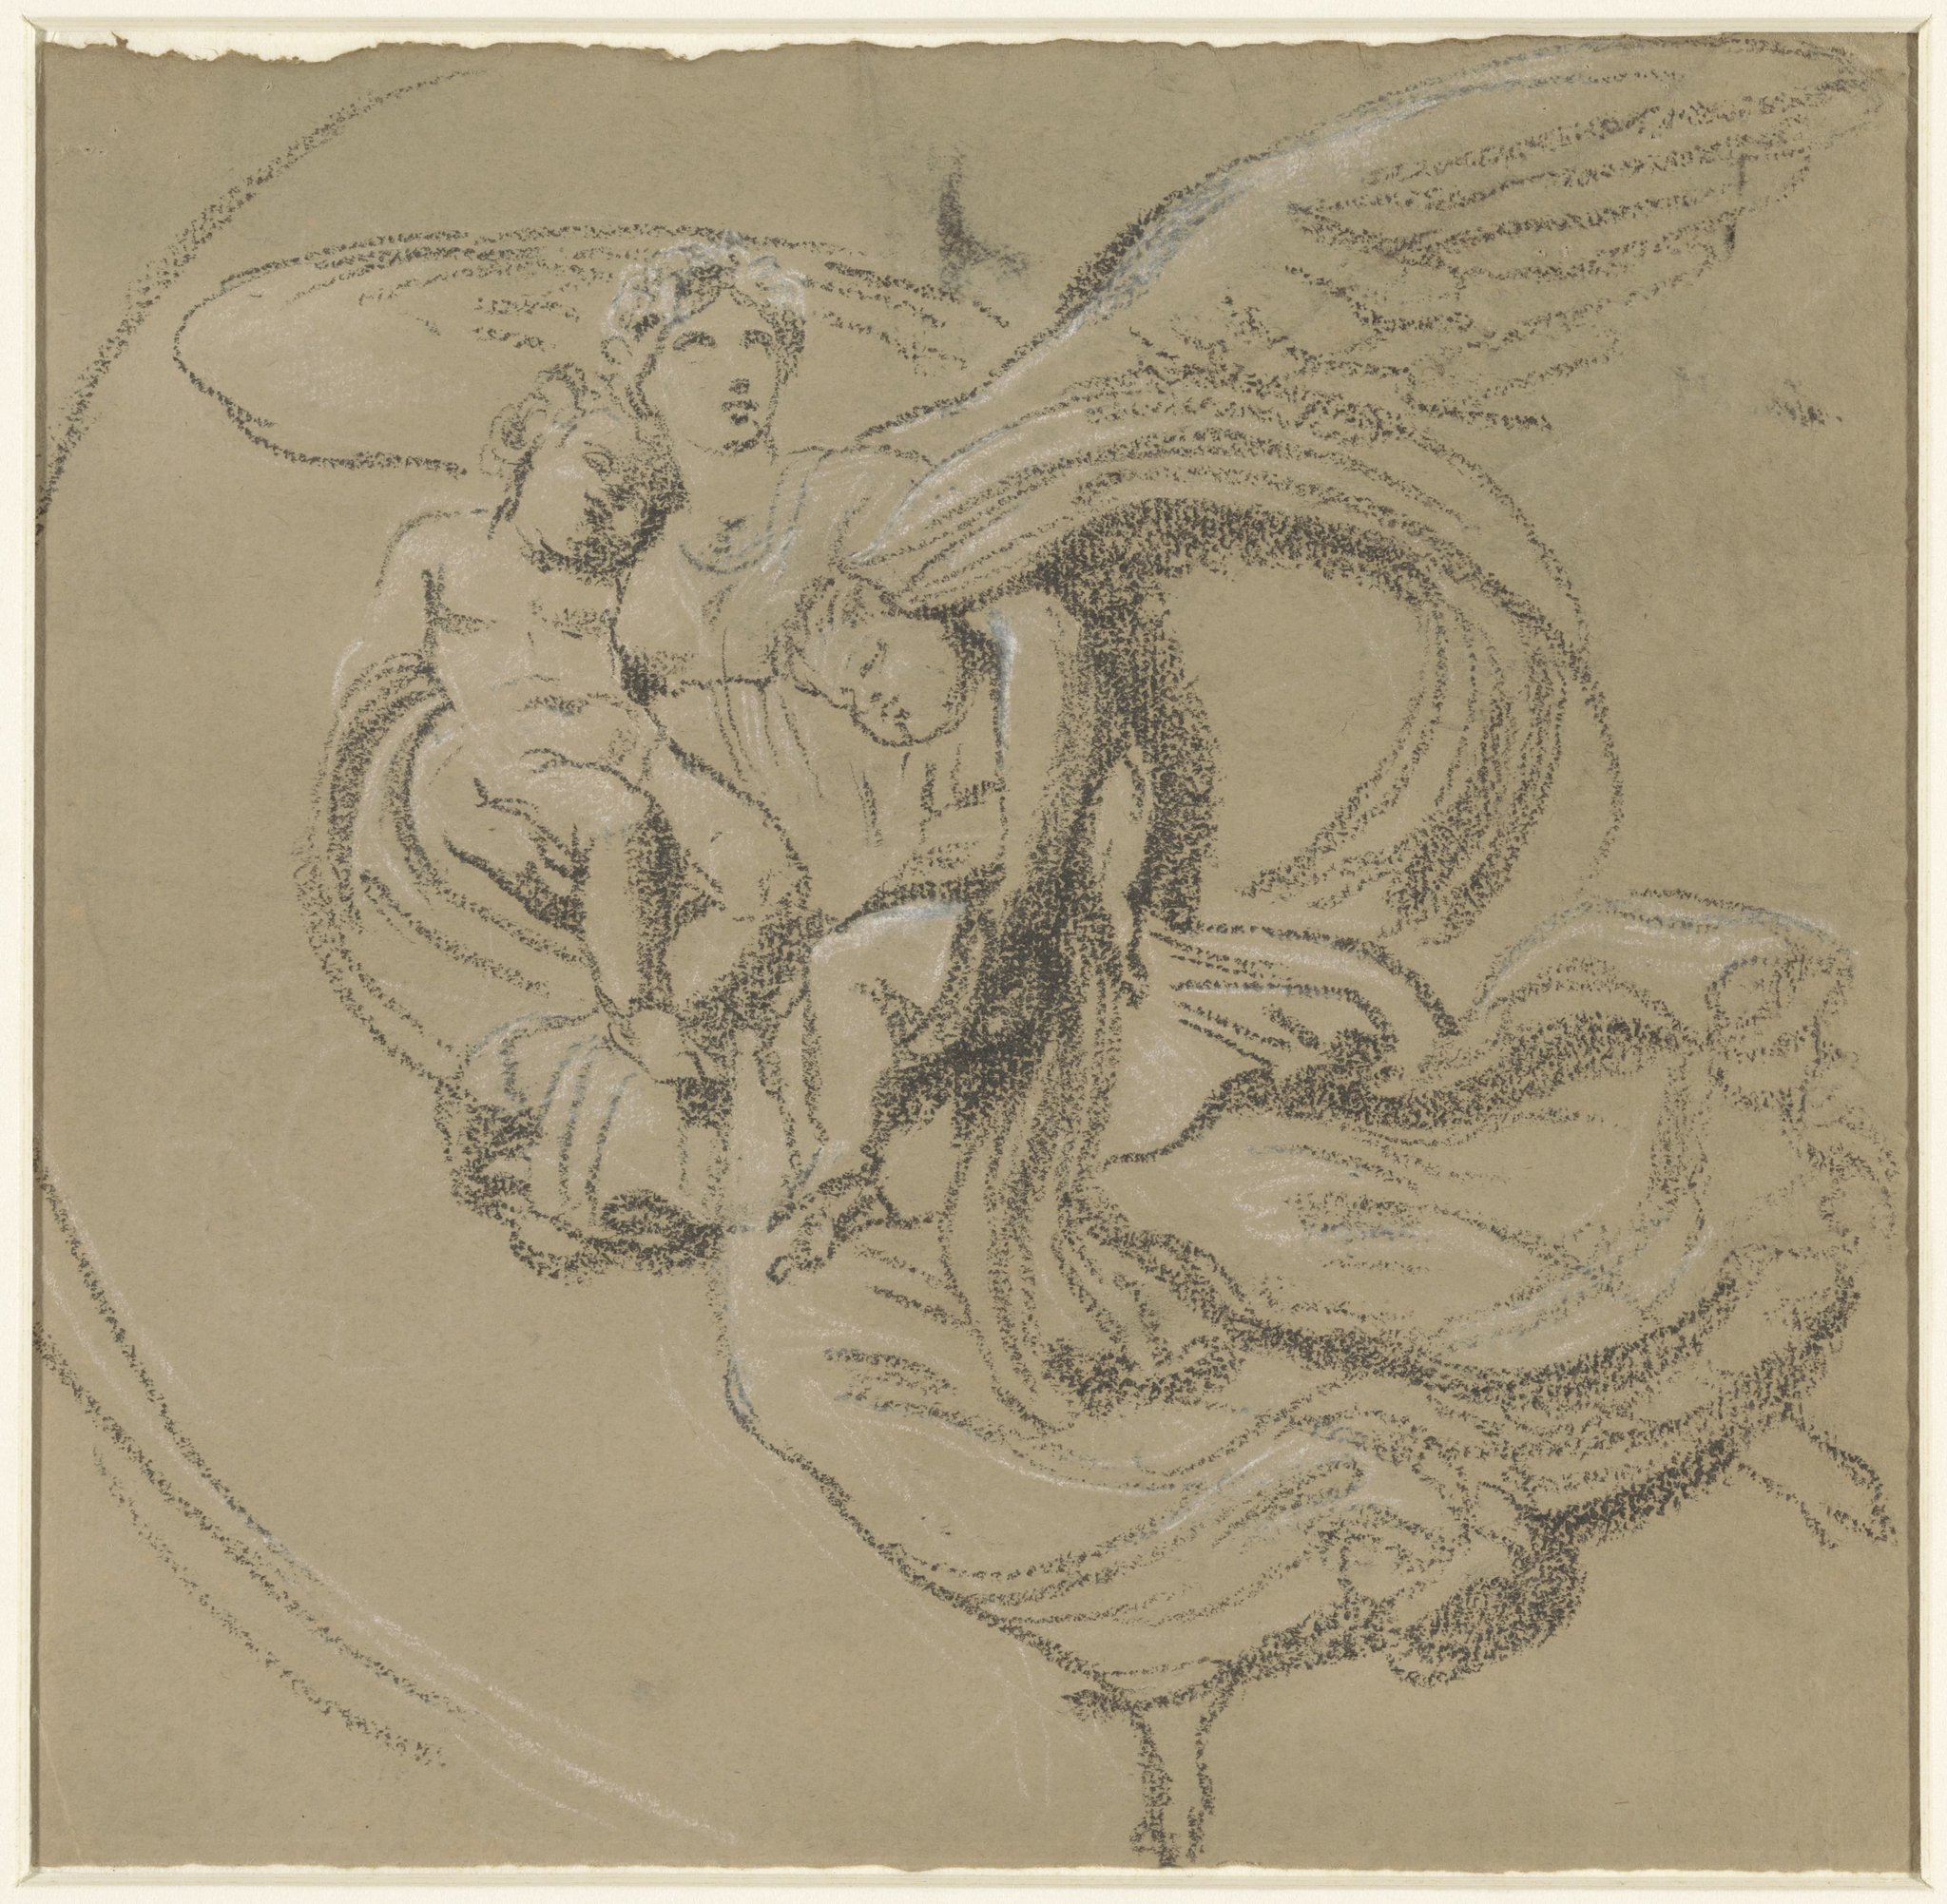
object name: design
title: Nacht: gevleugelde vrouwenfiguur, die met op iedere arm een kind naar links zweeft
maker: bertel thorvaldsen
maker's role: draughtsman, sculptor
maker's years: 1768-1844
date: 1800-1815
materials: chalk, paper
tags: night